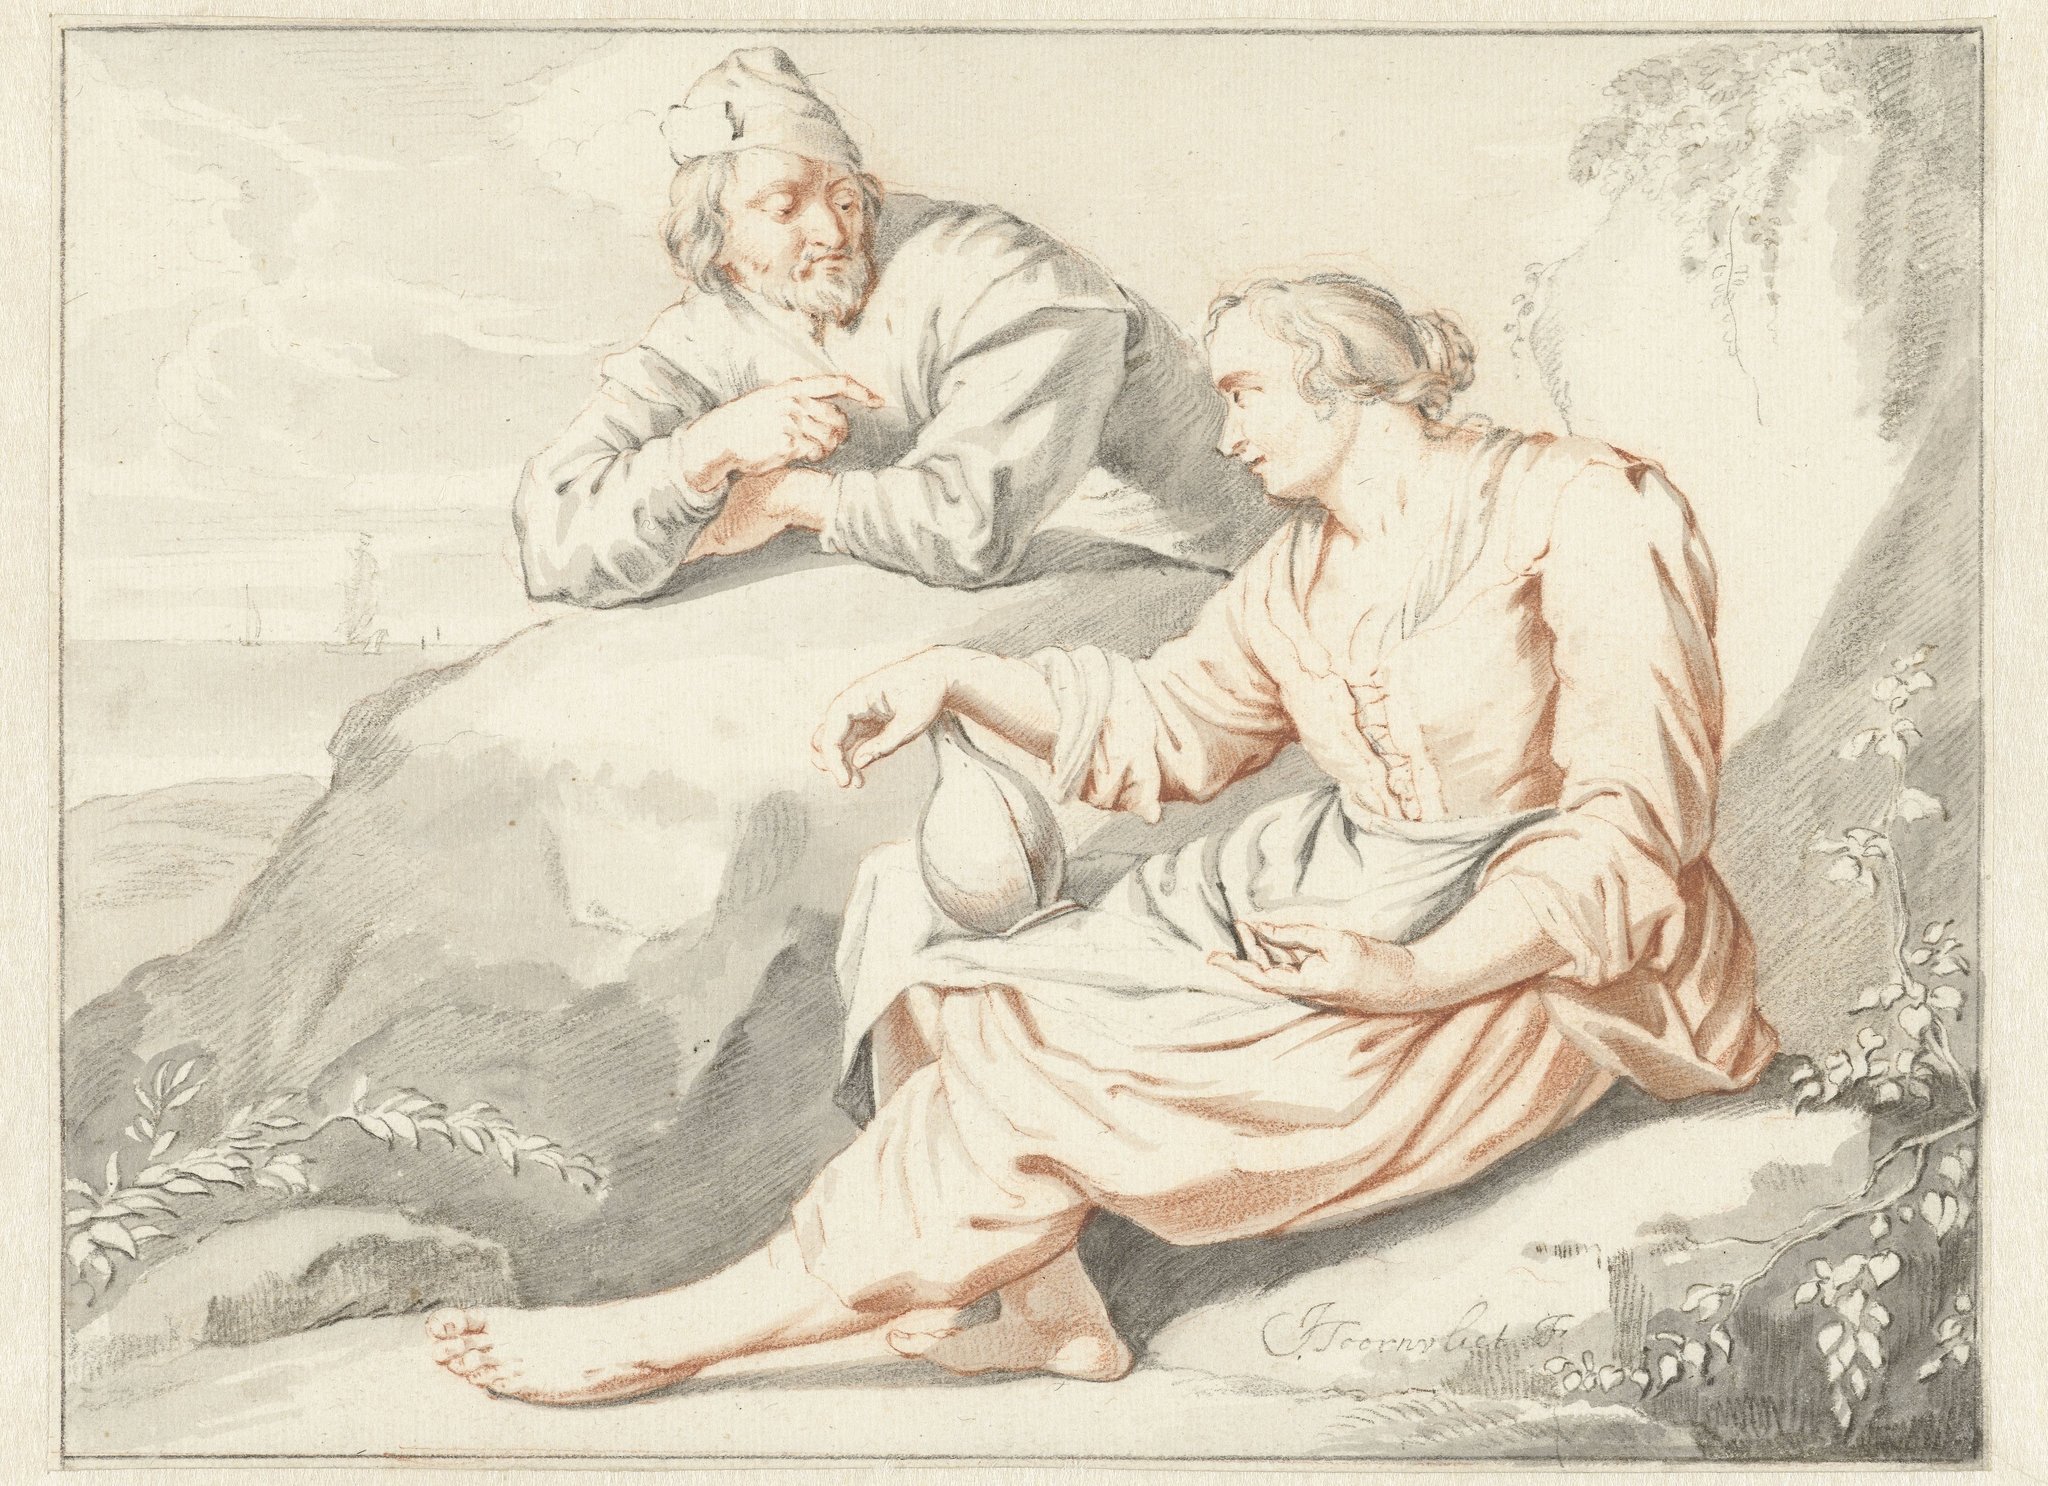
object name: drawing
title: Vrouw met een kruik in gesprek met een man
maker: jacob toorenvliet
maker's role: draughtsman, painter, print maker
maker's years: 1640-1719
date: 1650-1719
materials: chalk, paper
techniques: brush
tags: female sex; woman, pursuit of a woman, prowling, male sex; man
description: Een zittende vrouw met een kruik in gesprek met een op een rots leunende man.